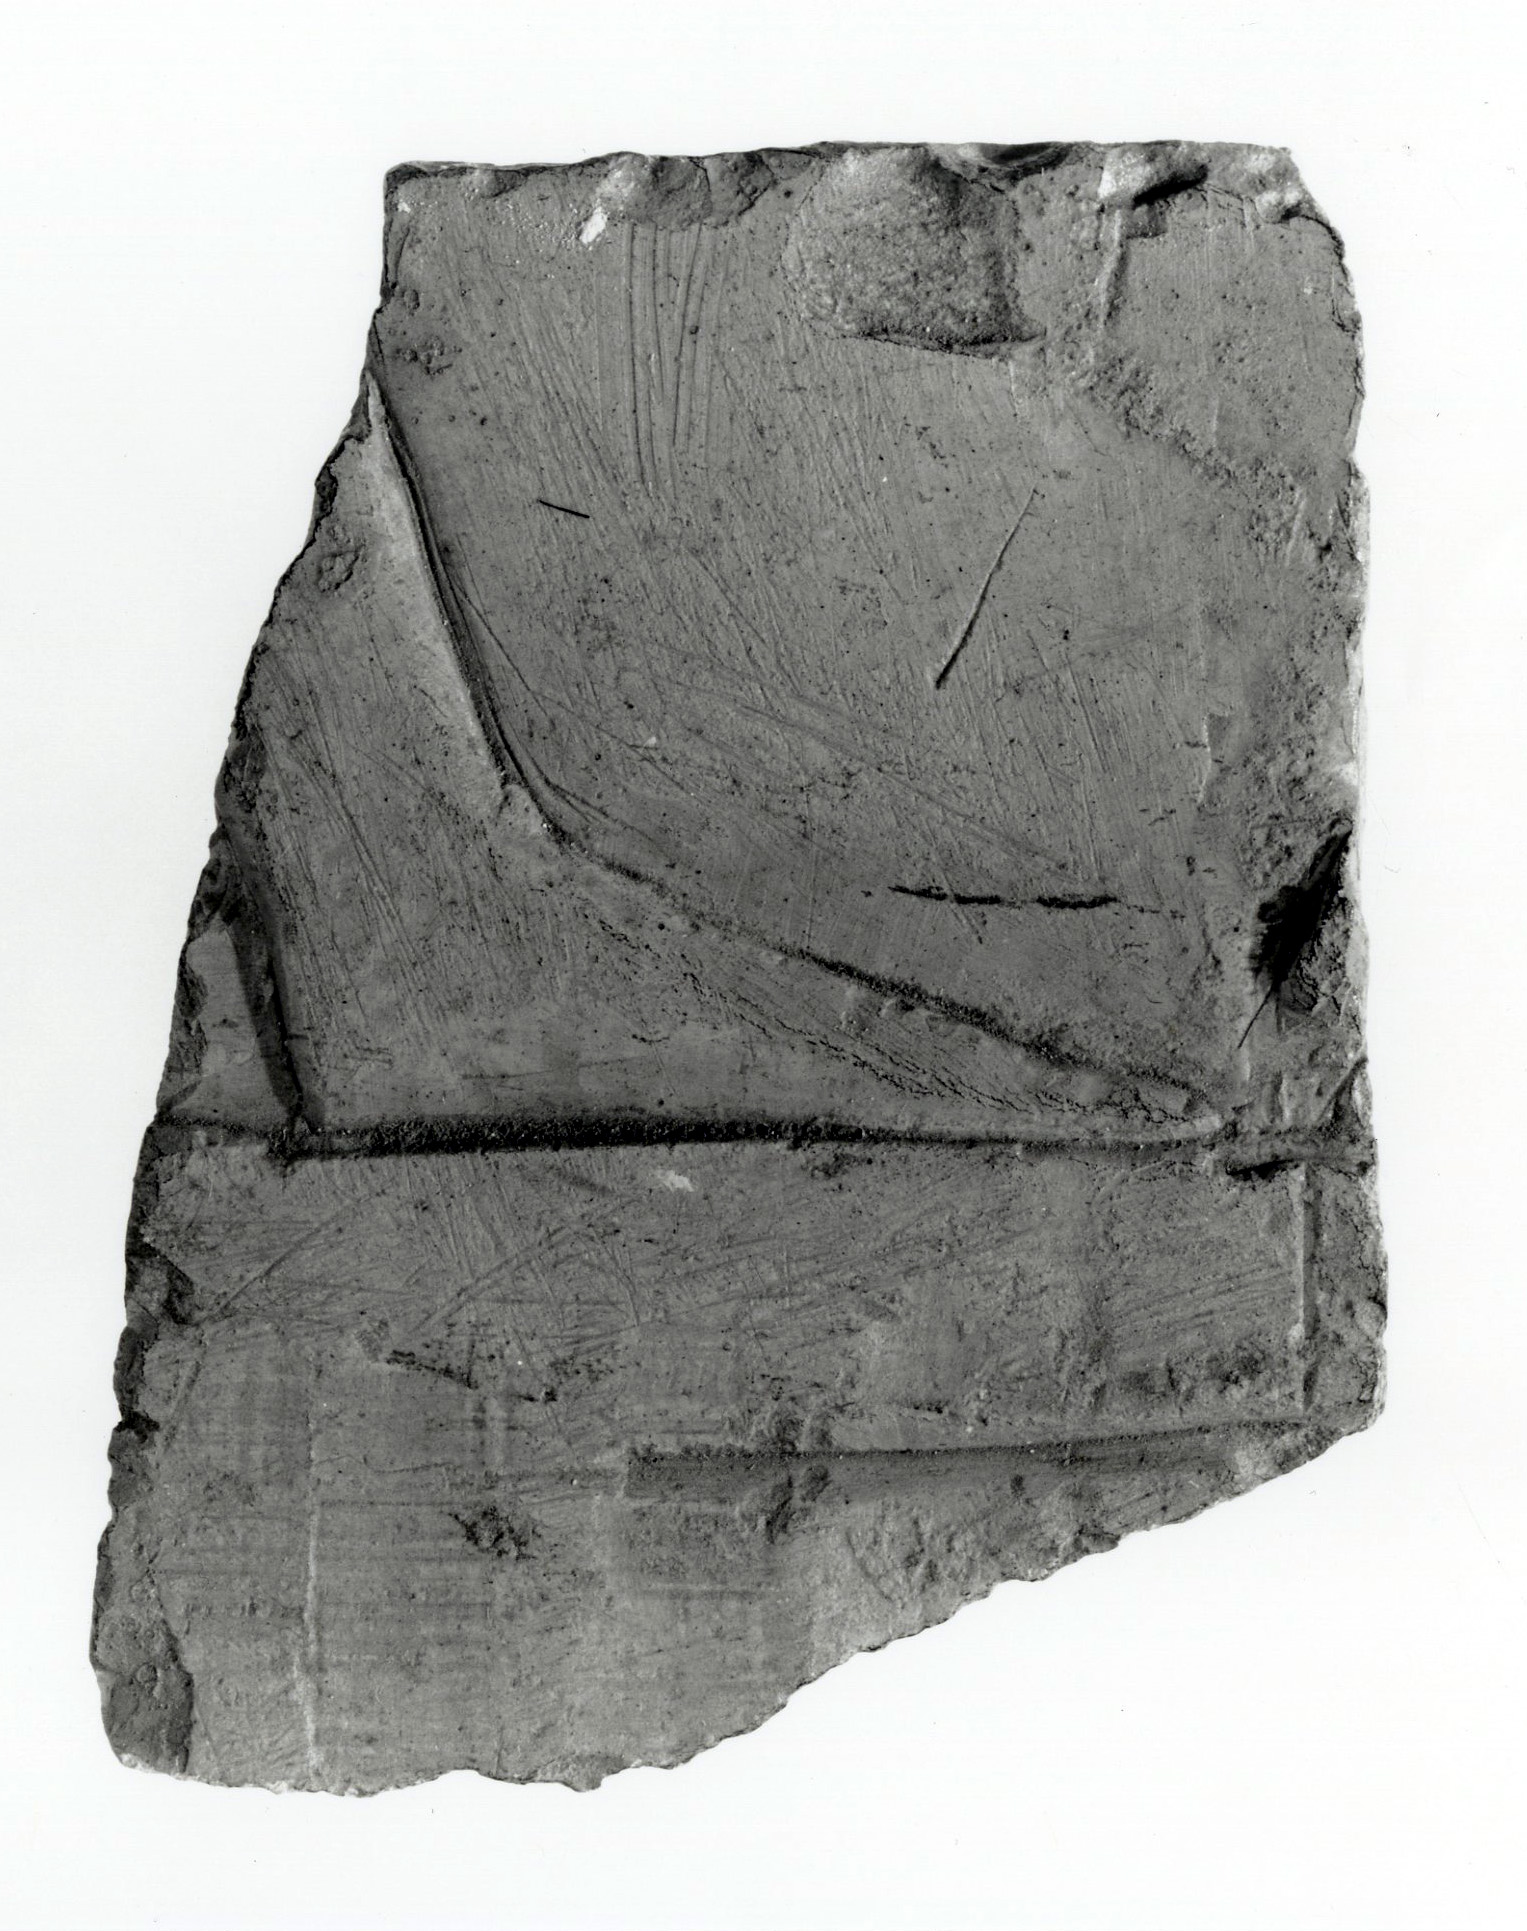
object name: relief, tomb of nespekashuty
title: Raised relief fragment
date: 664-610 BCE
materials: limestone, varnish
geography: egypt